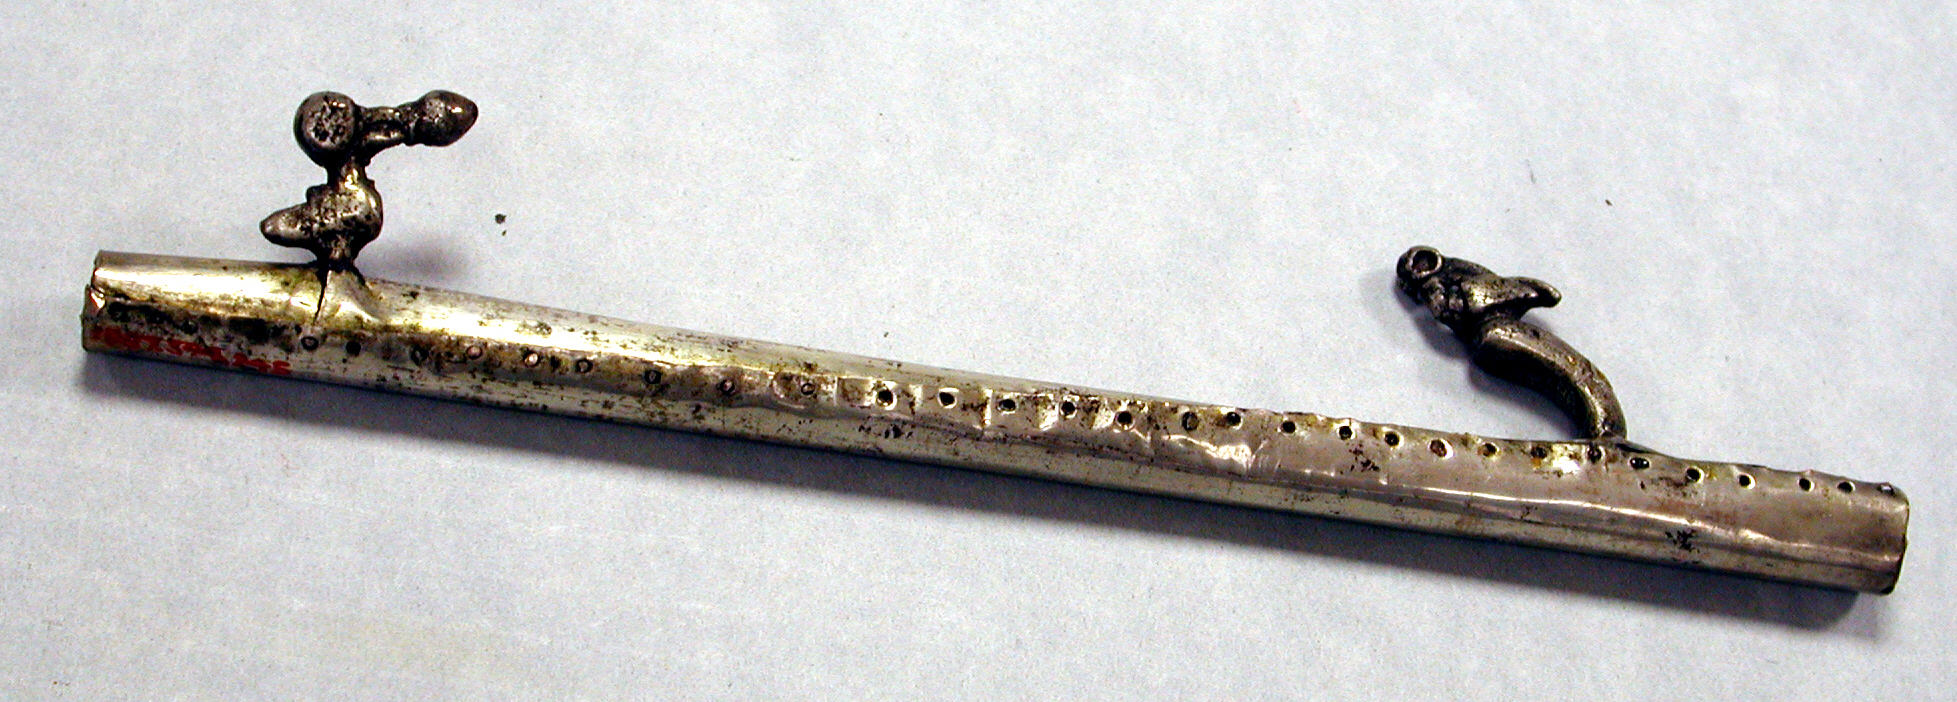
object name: spear thrower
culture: chimú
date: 1101-1500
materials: silver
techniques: casting, hammering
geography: peru